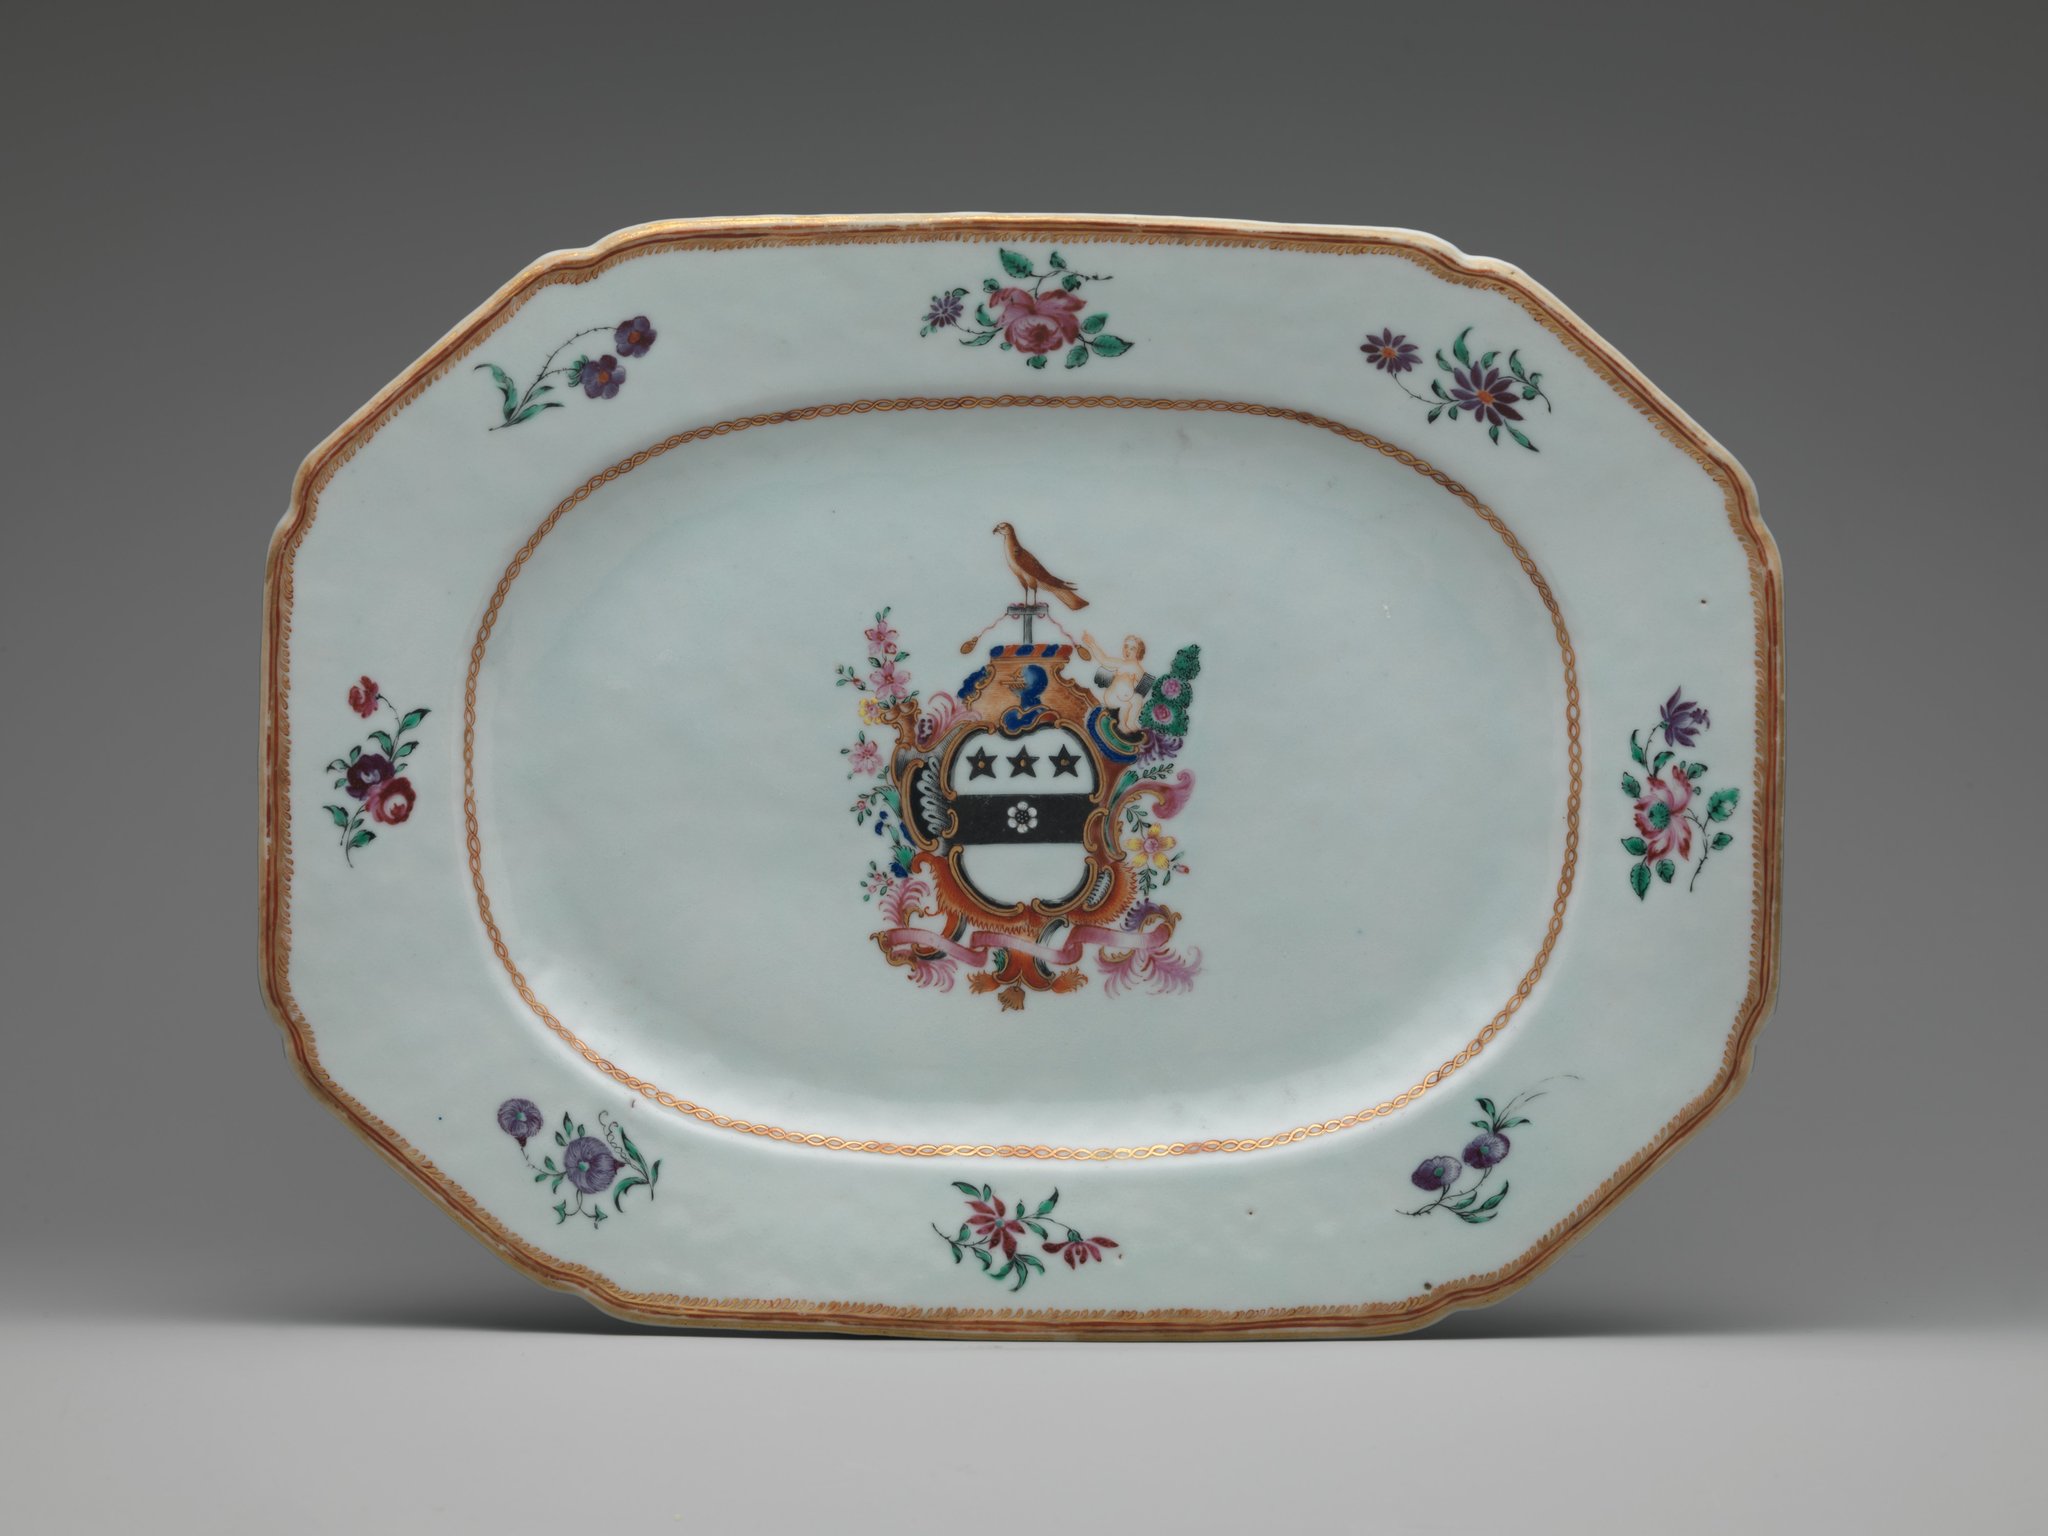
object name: platter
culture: chinese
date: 1785-1790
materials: porcelain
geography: china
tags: birds,coat of arms